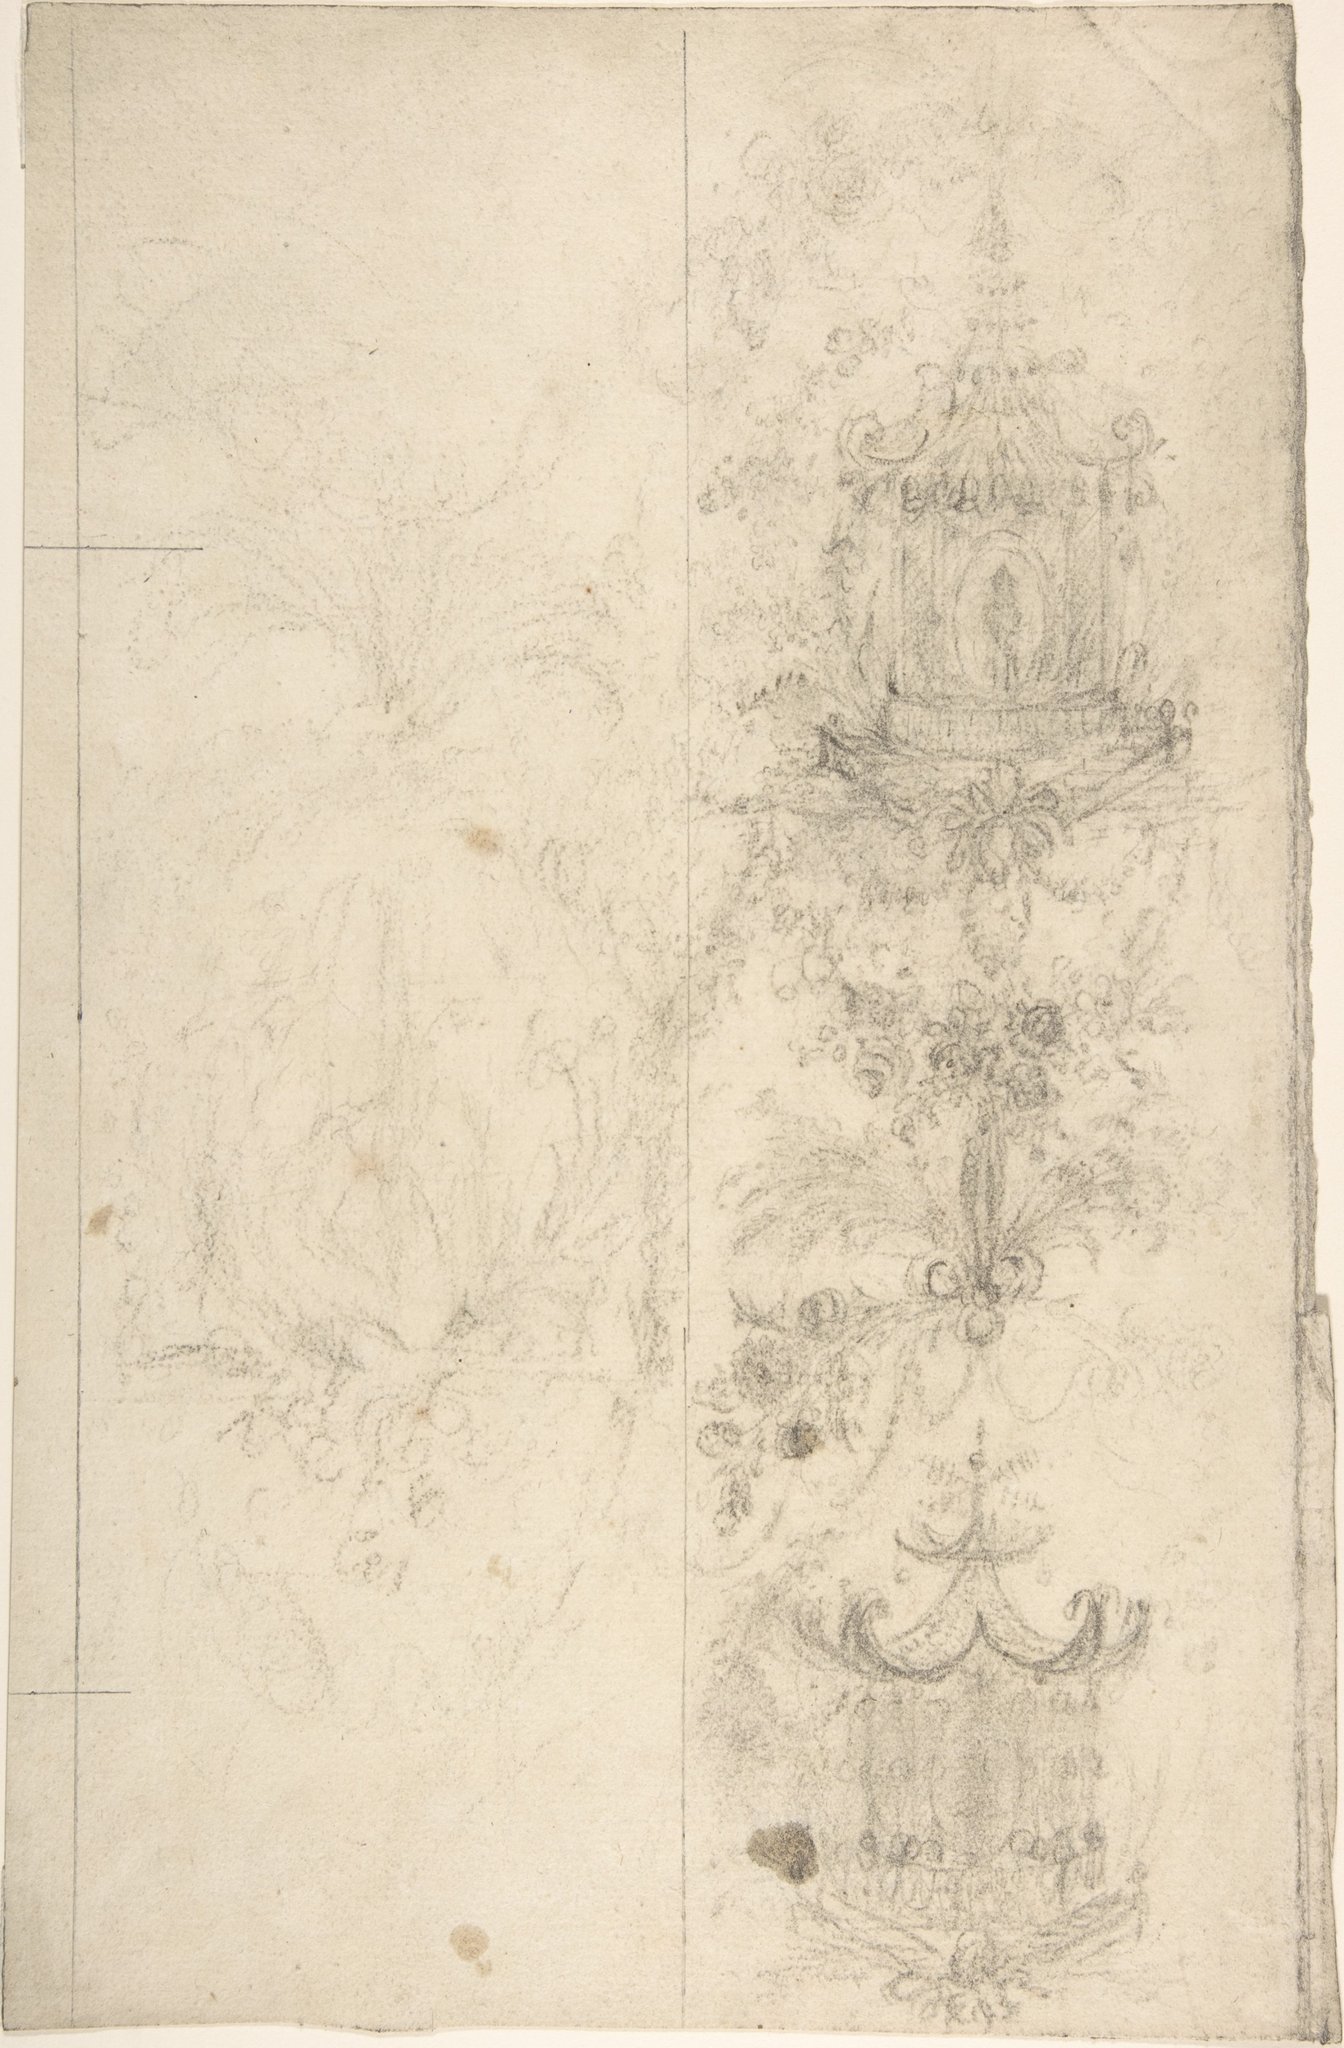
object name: drawing ornament architecture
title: Two Designs for Chinese Lanterns, possibly meant for the Decoration of a Wall Panel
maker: anonymous, french, 18th century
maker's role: artist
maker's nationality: french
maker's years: 1700-1800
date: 1768-1780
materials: graphite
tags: chinoiserie